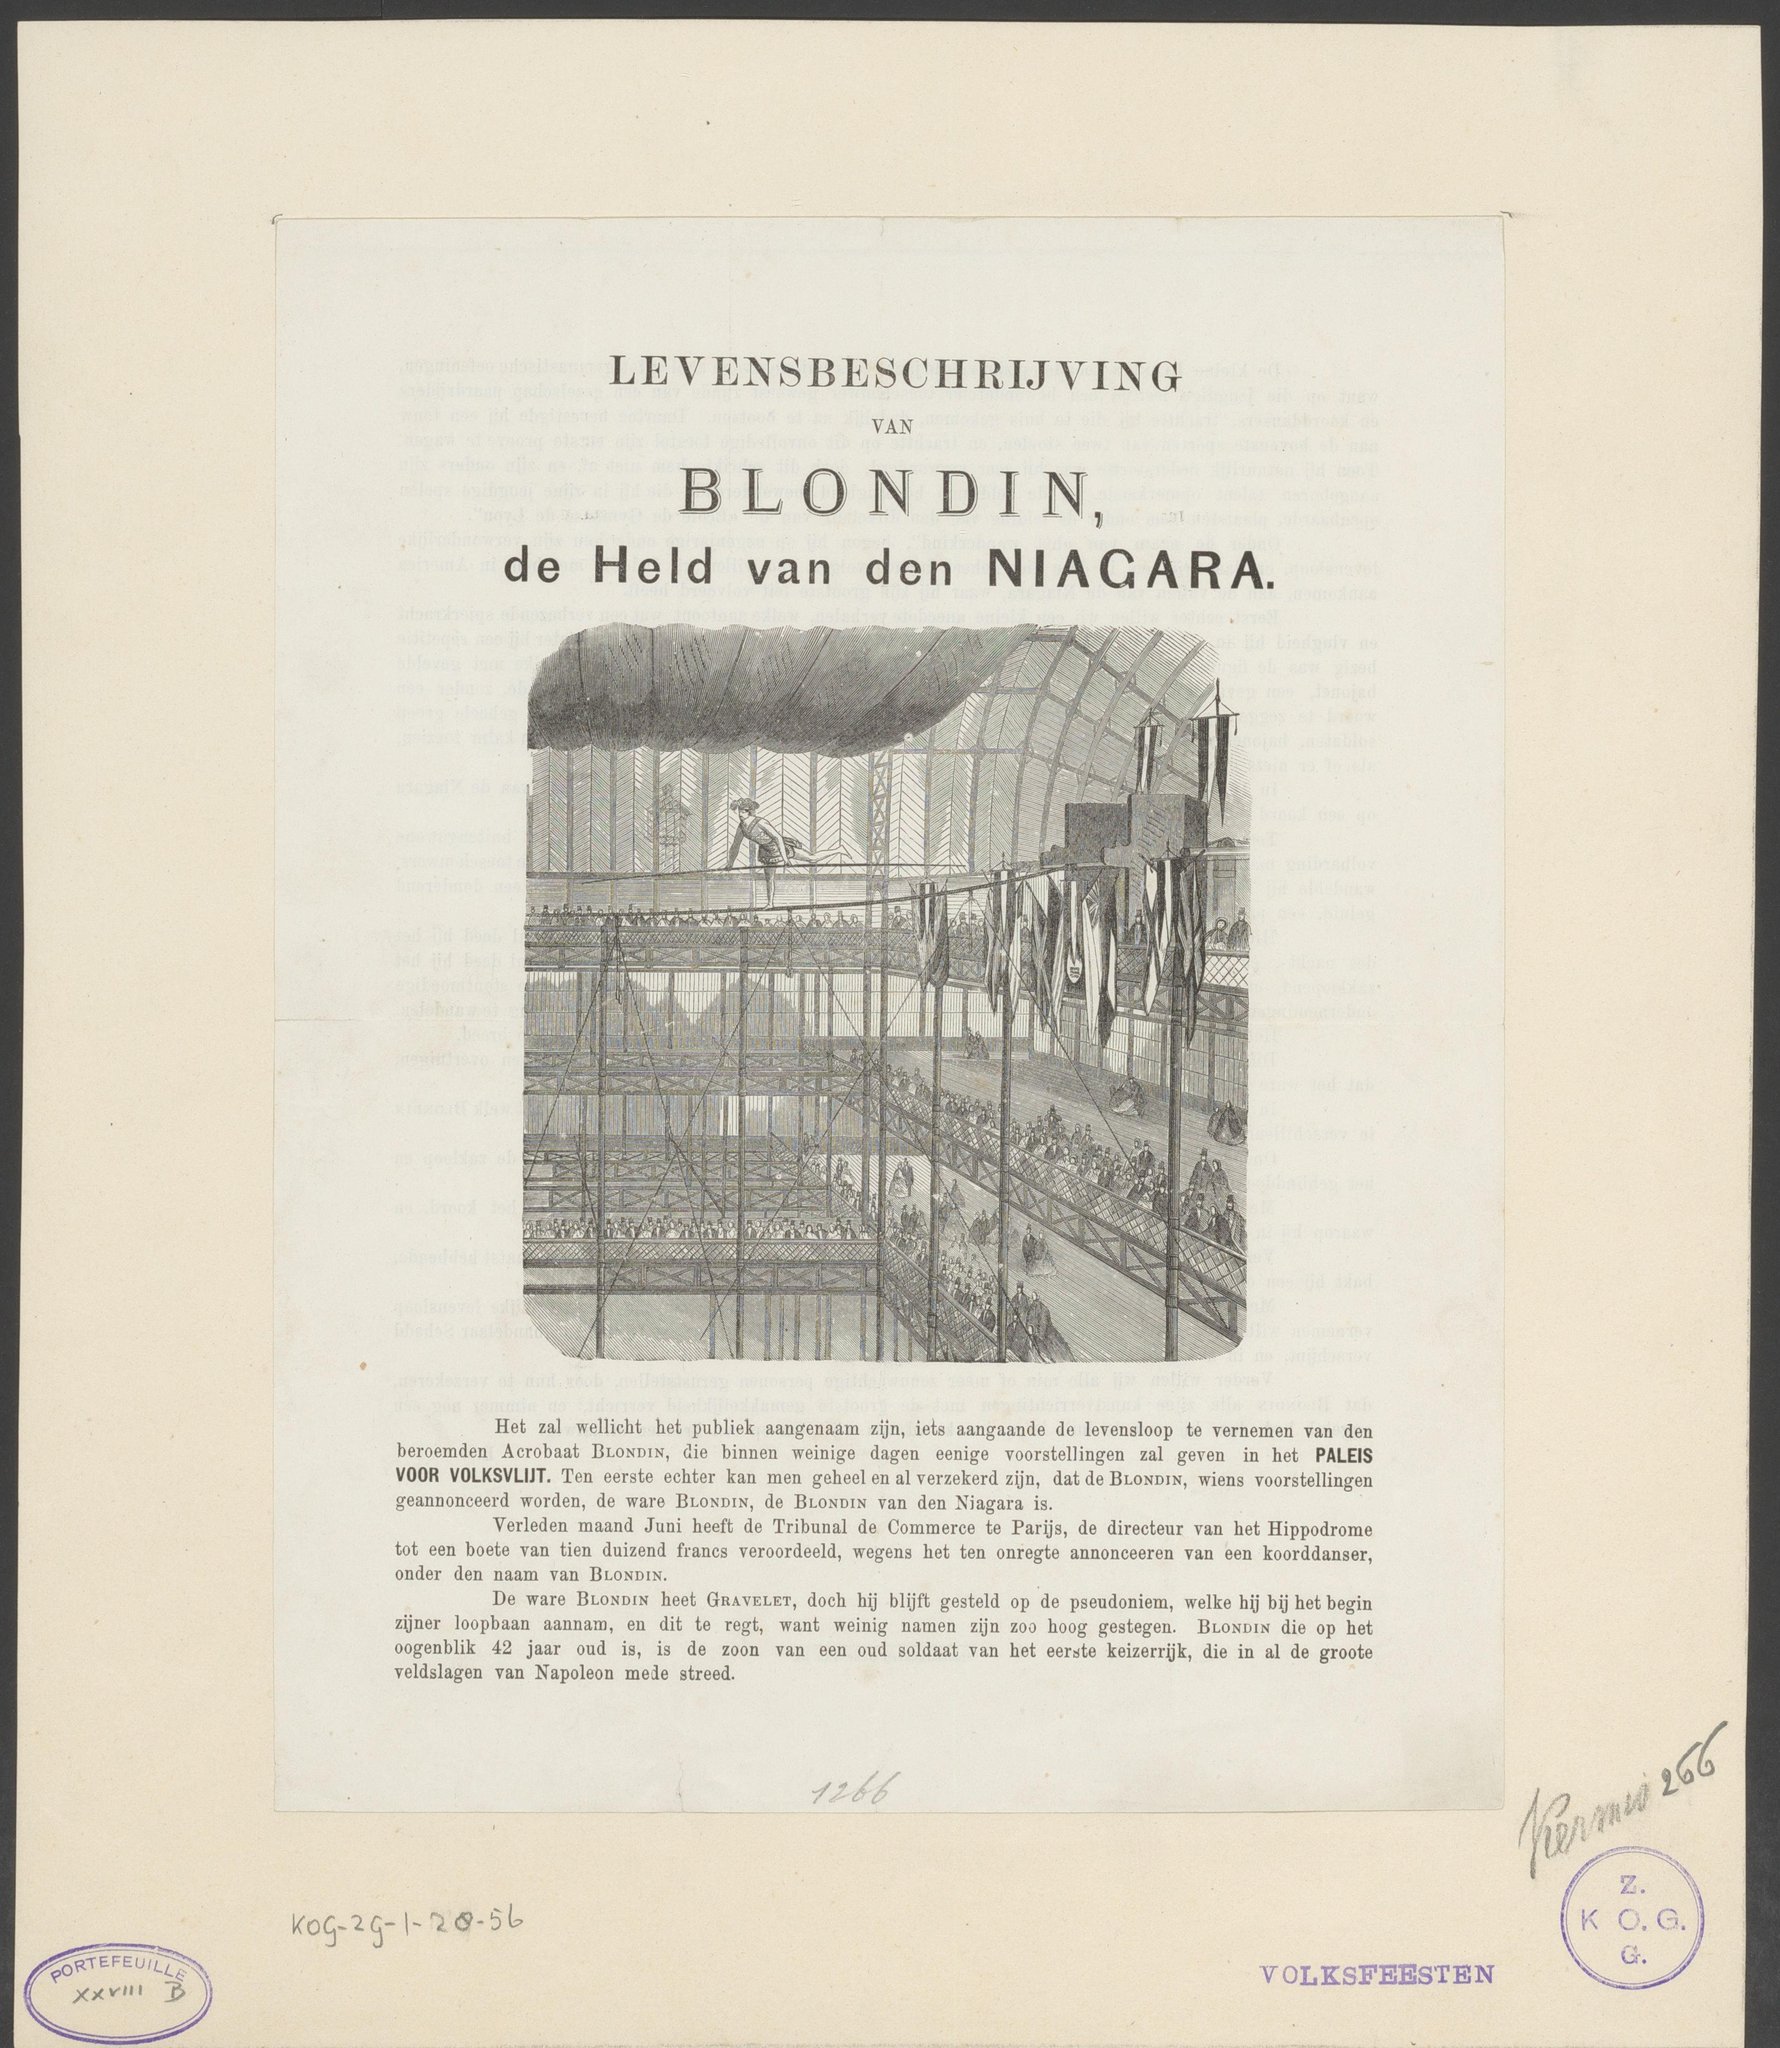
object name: print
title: Koorddanser Charles Blondin in het Paleis voor Volksvlijt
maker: Anonymous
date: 1828-1831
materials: paper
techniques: engraving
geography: amsterdam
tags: acrobat ~ circus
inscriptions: stamp, stamp, collector's mark: Lugt 1641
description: Onderwerpsrubrieken binnen de Atlas Zeden en Gewoonten: Zeden en Gewoonten in Engeren Zin. Volksleven. Volksfeesten. Circusmenschen, dierentemmers, acrobaten, goochelaars, en dergelijken.